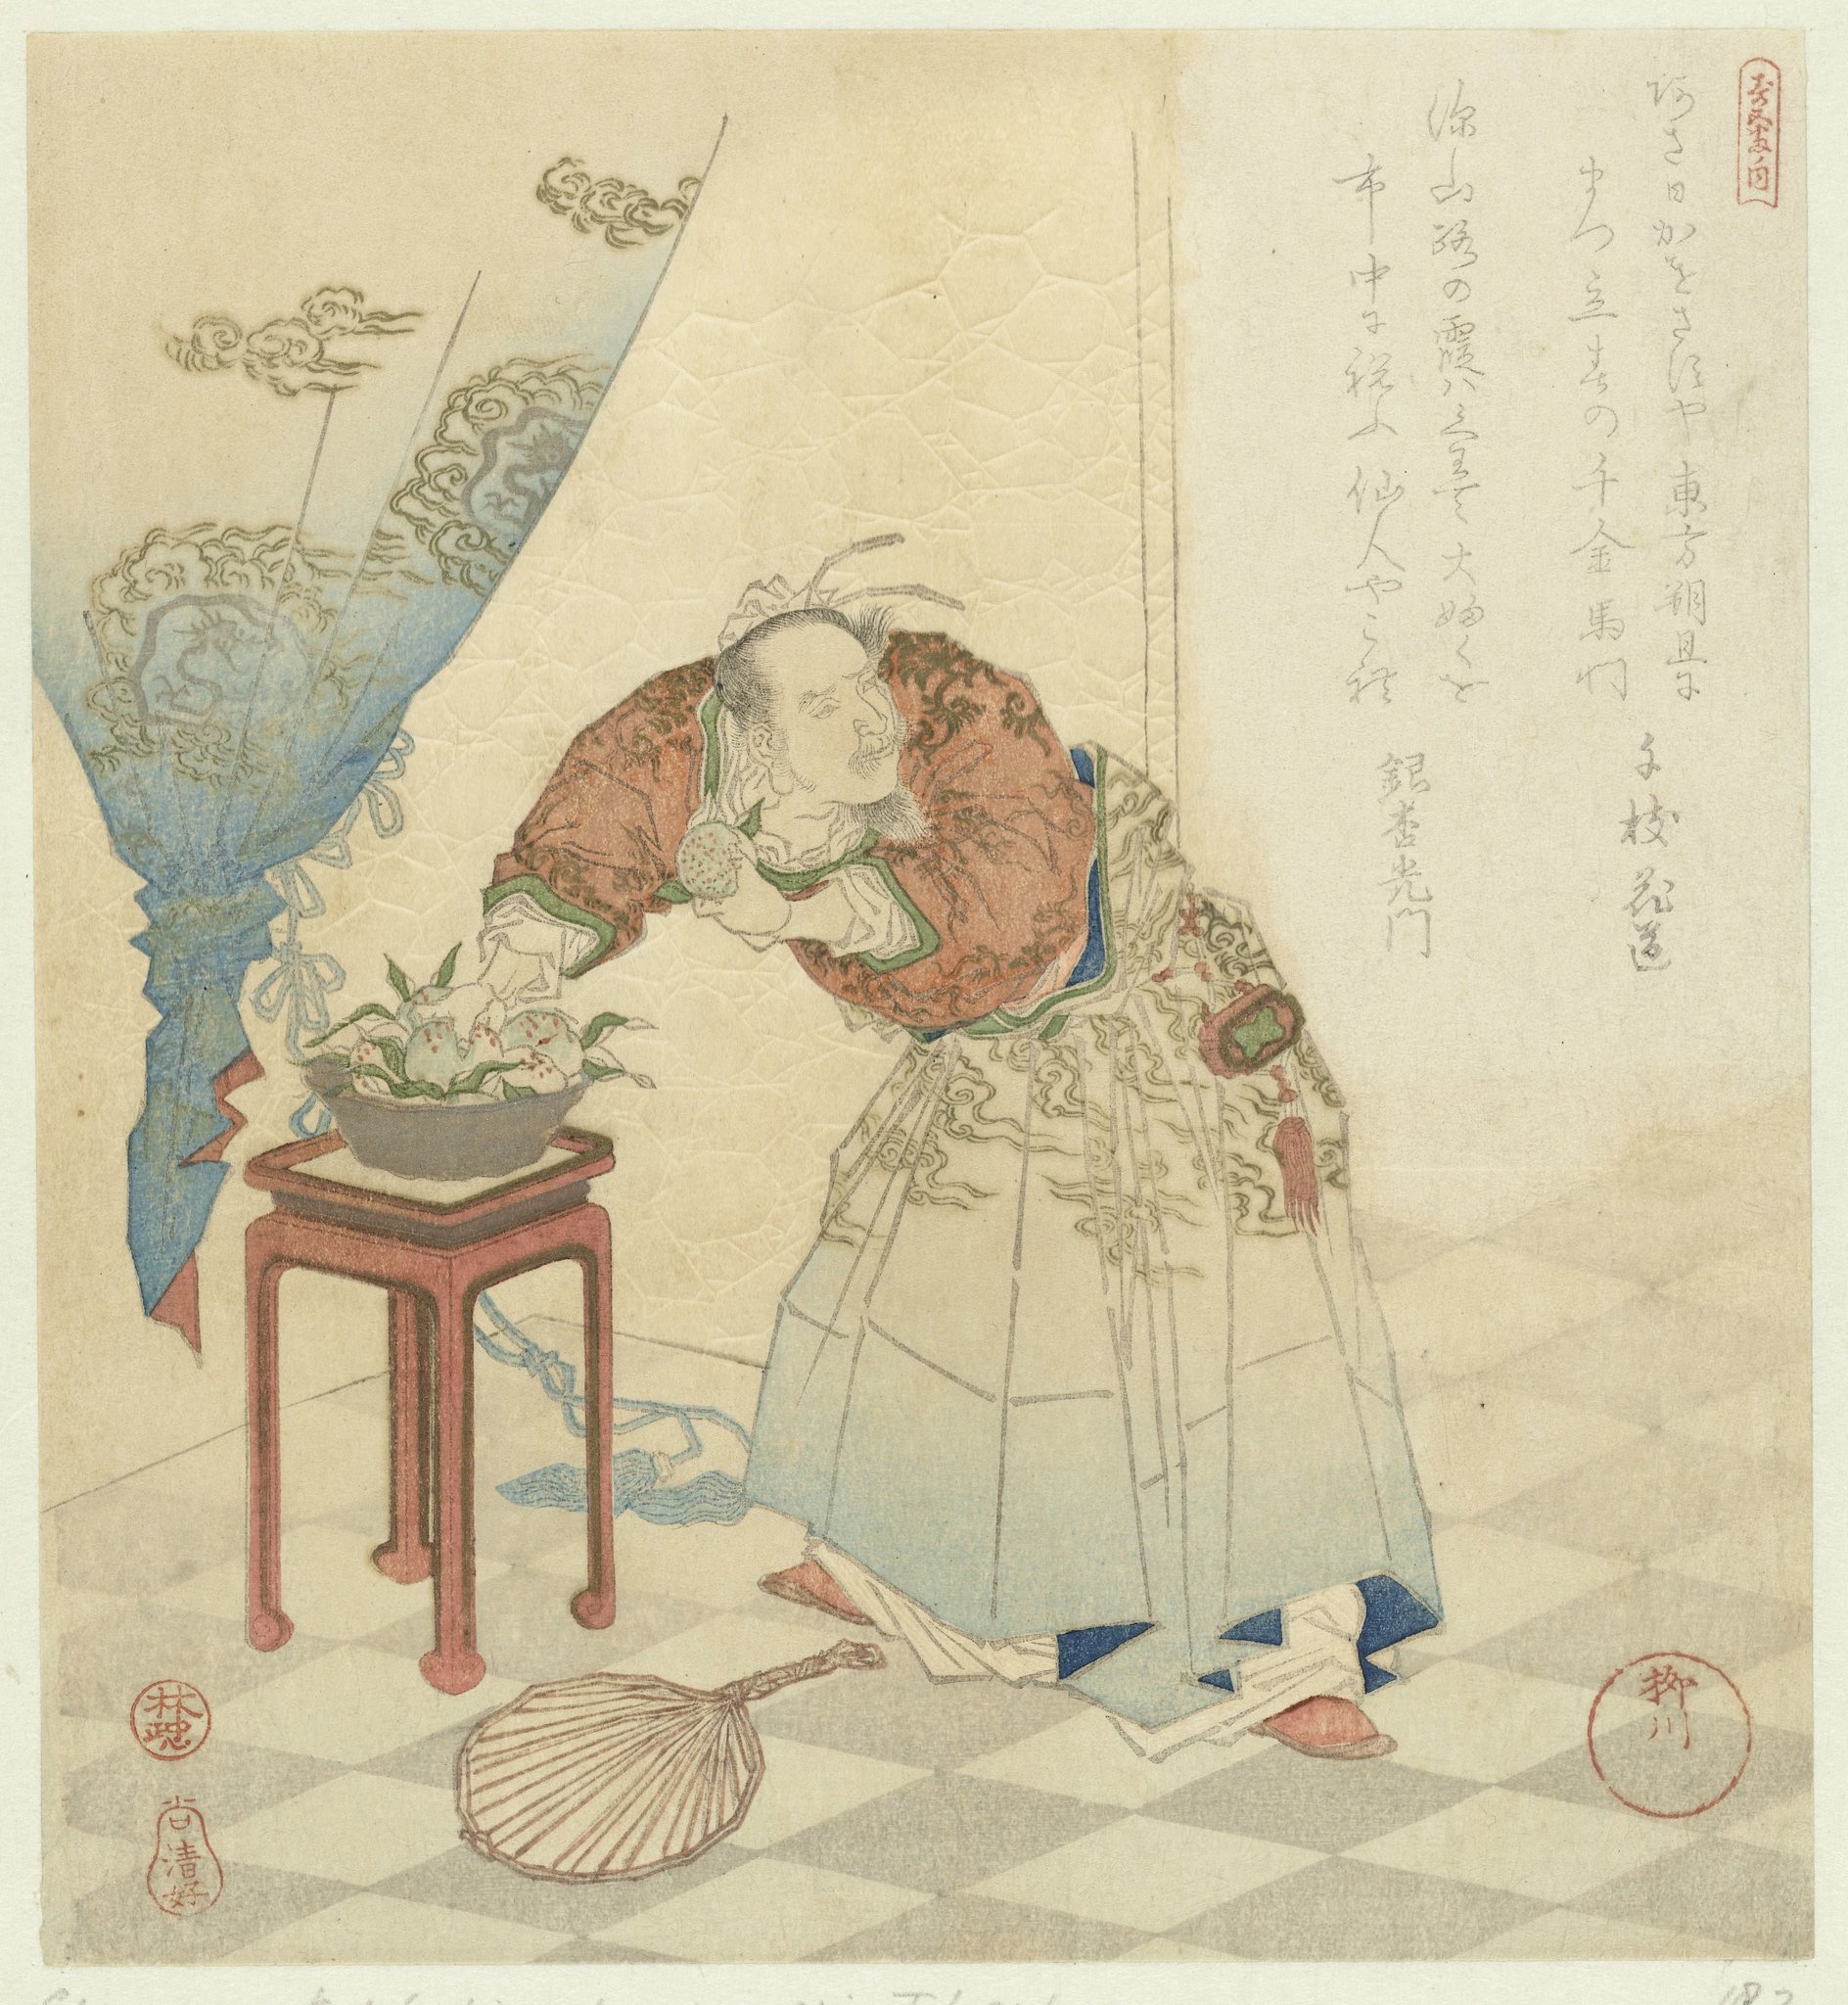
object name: surimono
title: Tôbôsaku steelt onsterfelijkheidsperziken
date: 1822-1828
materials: paper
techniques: blind stamped, woodcut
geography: japan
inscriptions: collector's mark, recto, stamped: Lugt 2971, collector's mark, passe-partout, bottom left, printed: JABdH with a rooster., collector's mark, verso, stamped: Lugt 2228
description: Een surimono is een luxe uitgevoerde prent waarop beeld met één of meerdere gedichten gecombineerd is. Bij het drukken van een surimono werd vaak gebruik gemaakt van dikker papier, blinddruk en metaal pigmenten, zoals koper- en zilverpoeder. De prenten werden vaak in opdracht van dichters gemaakt en als exclusief geschenk aan vrienden en relaties gegeven.